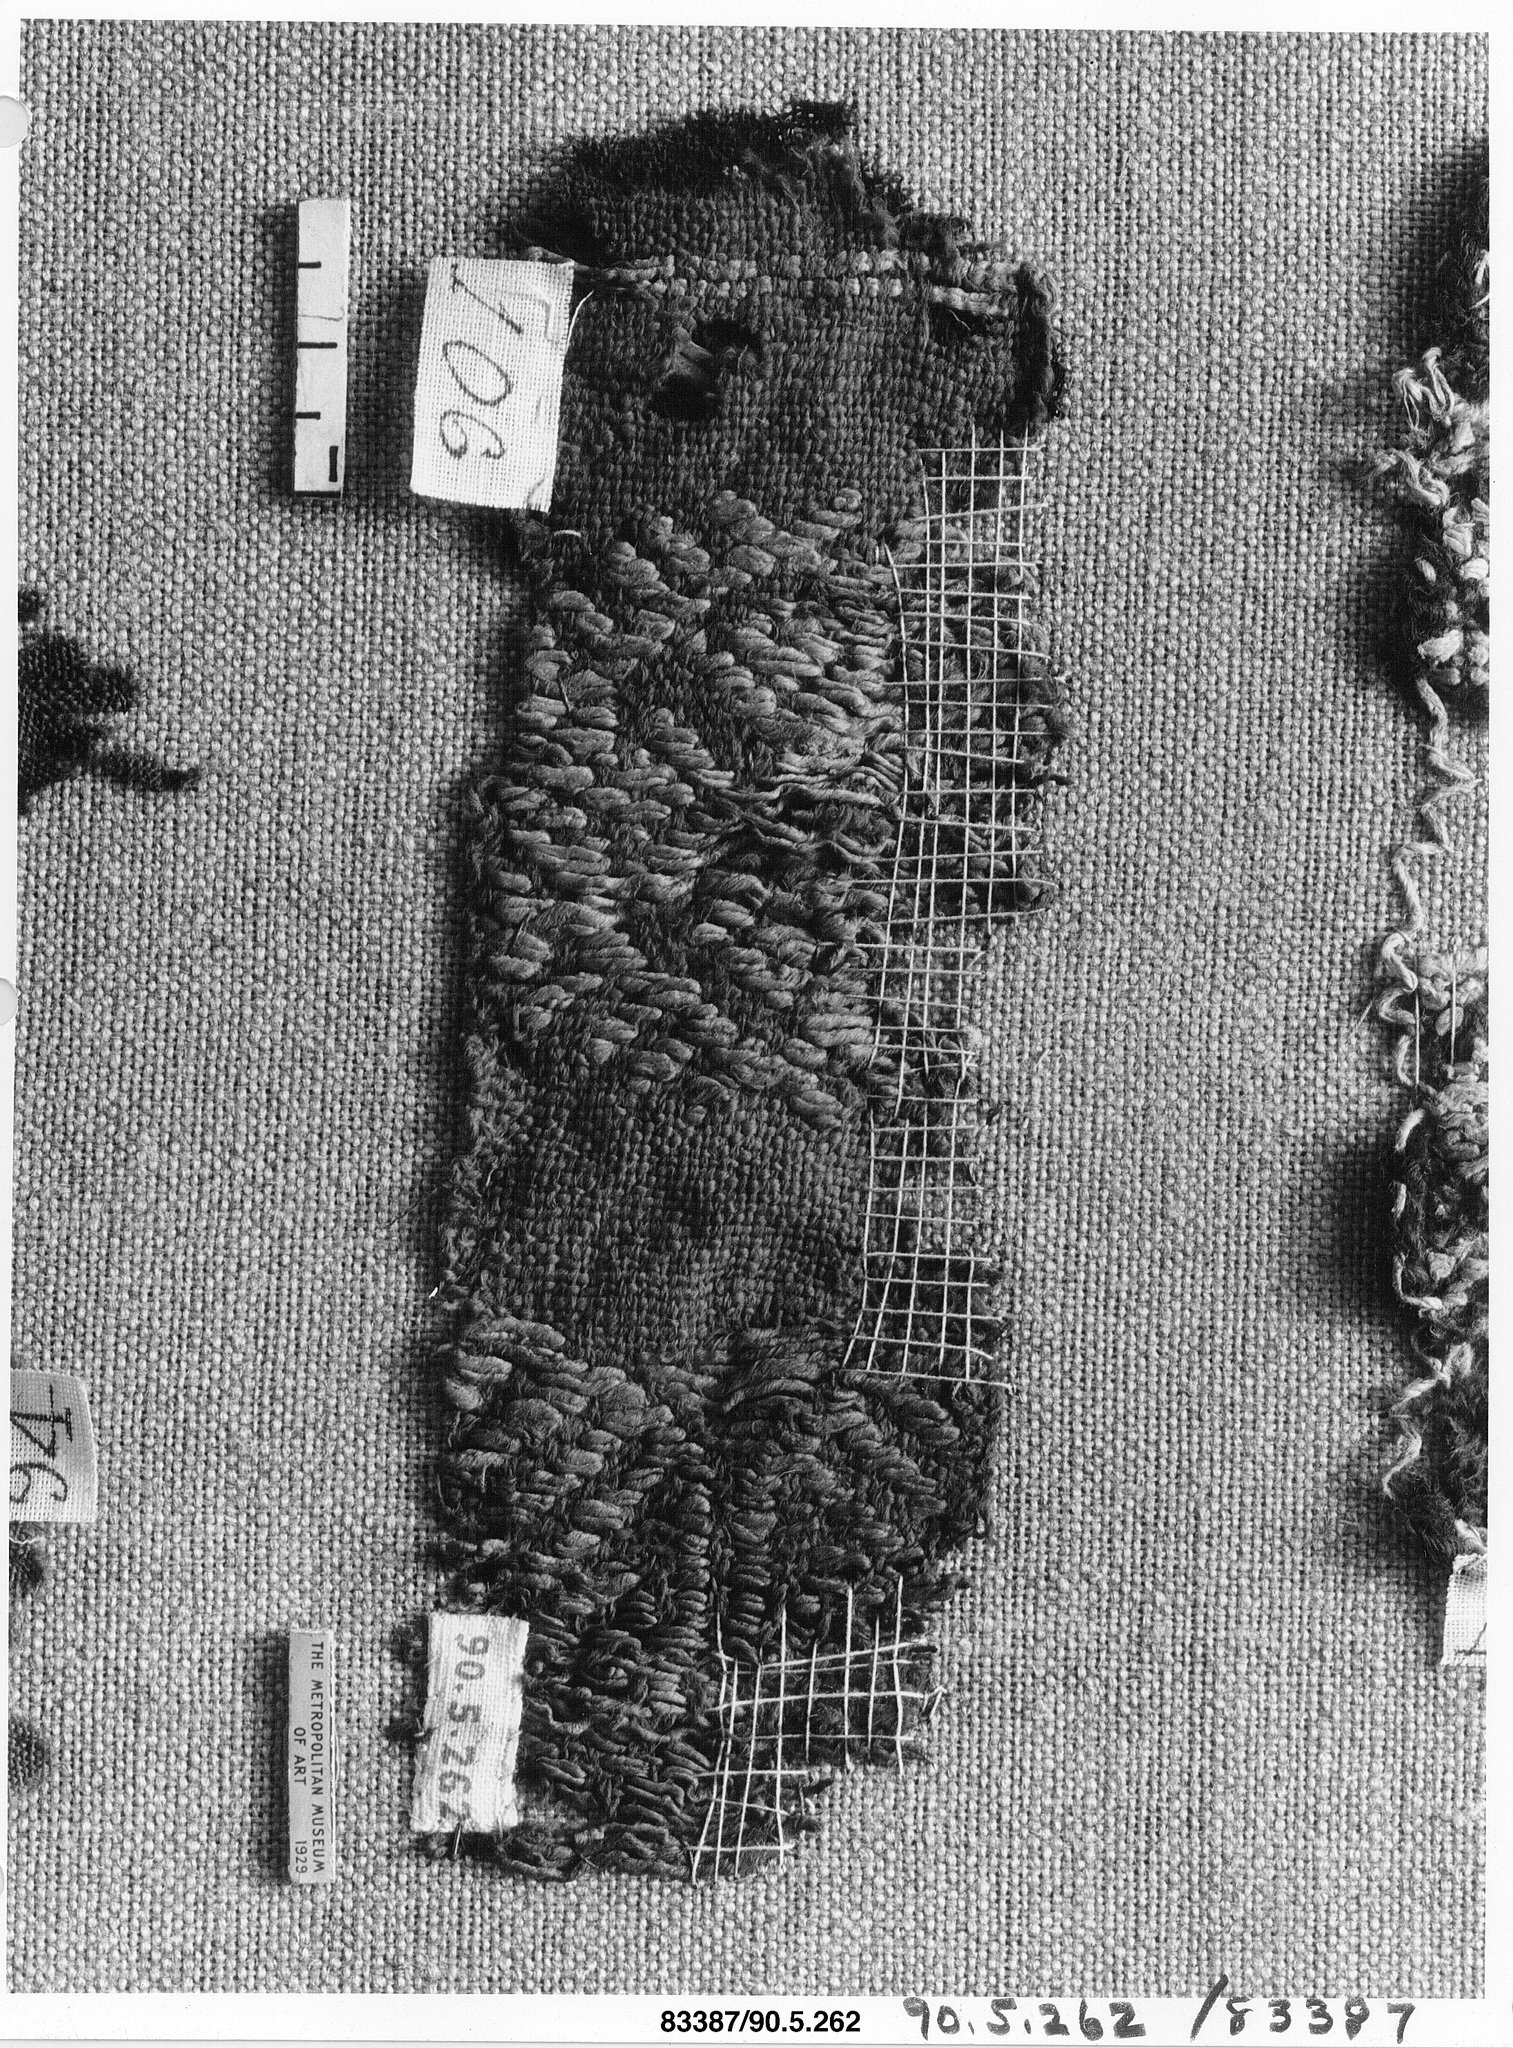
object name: textile fragment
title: Fragment of a Band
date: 501-600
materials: linen, wool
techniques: weave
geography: egypt